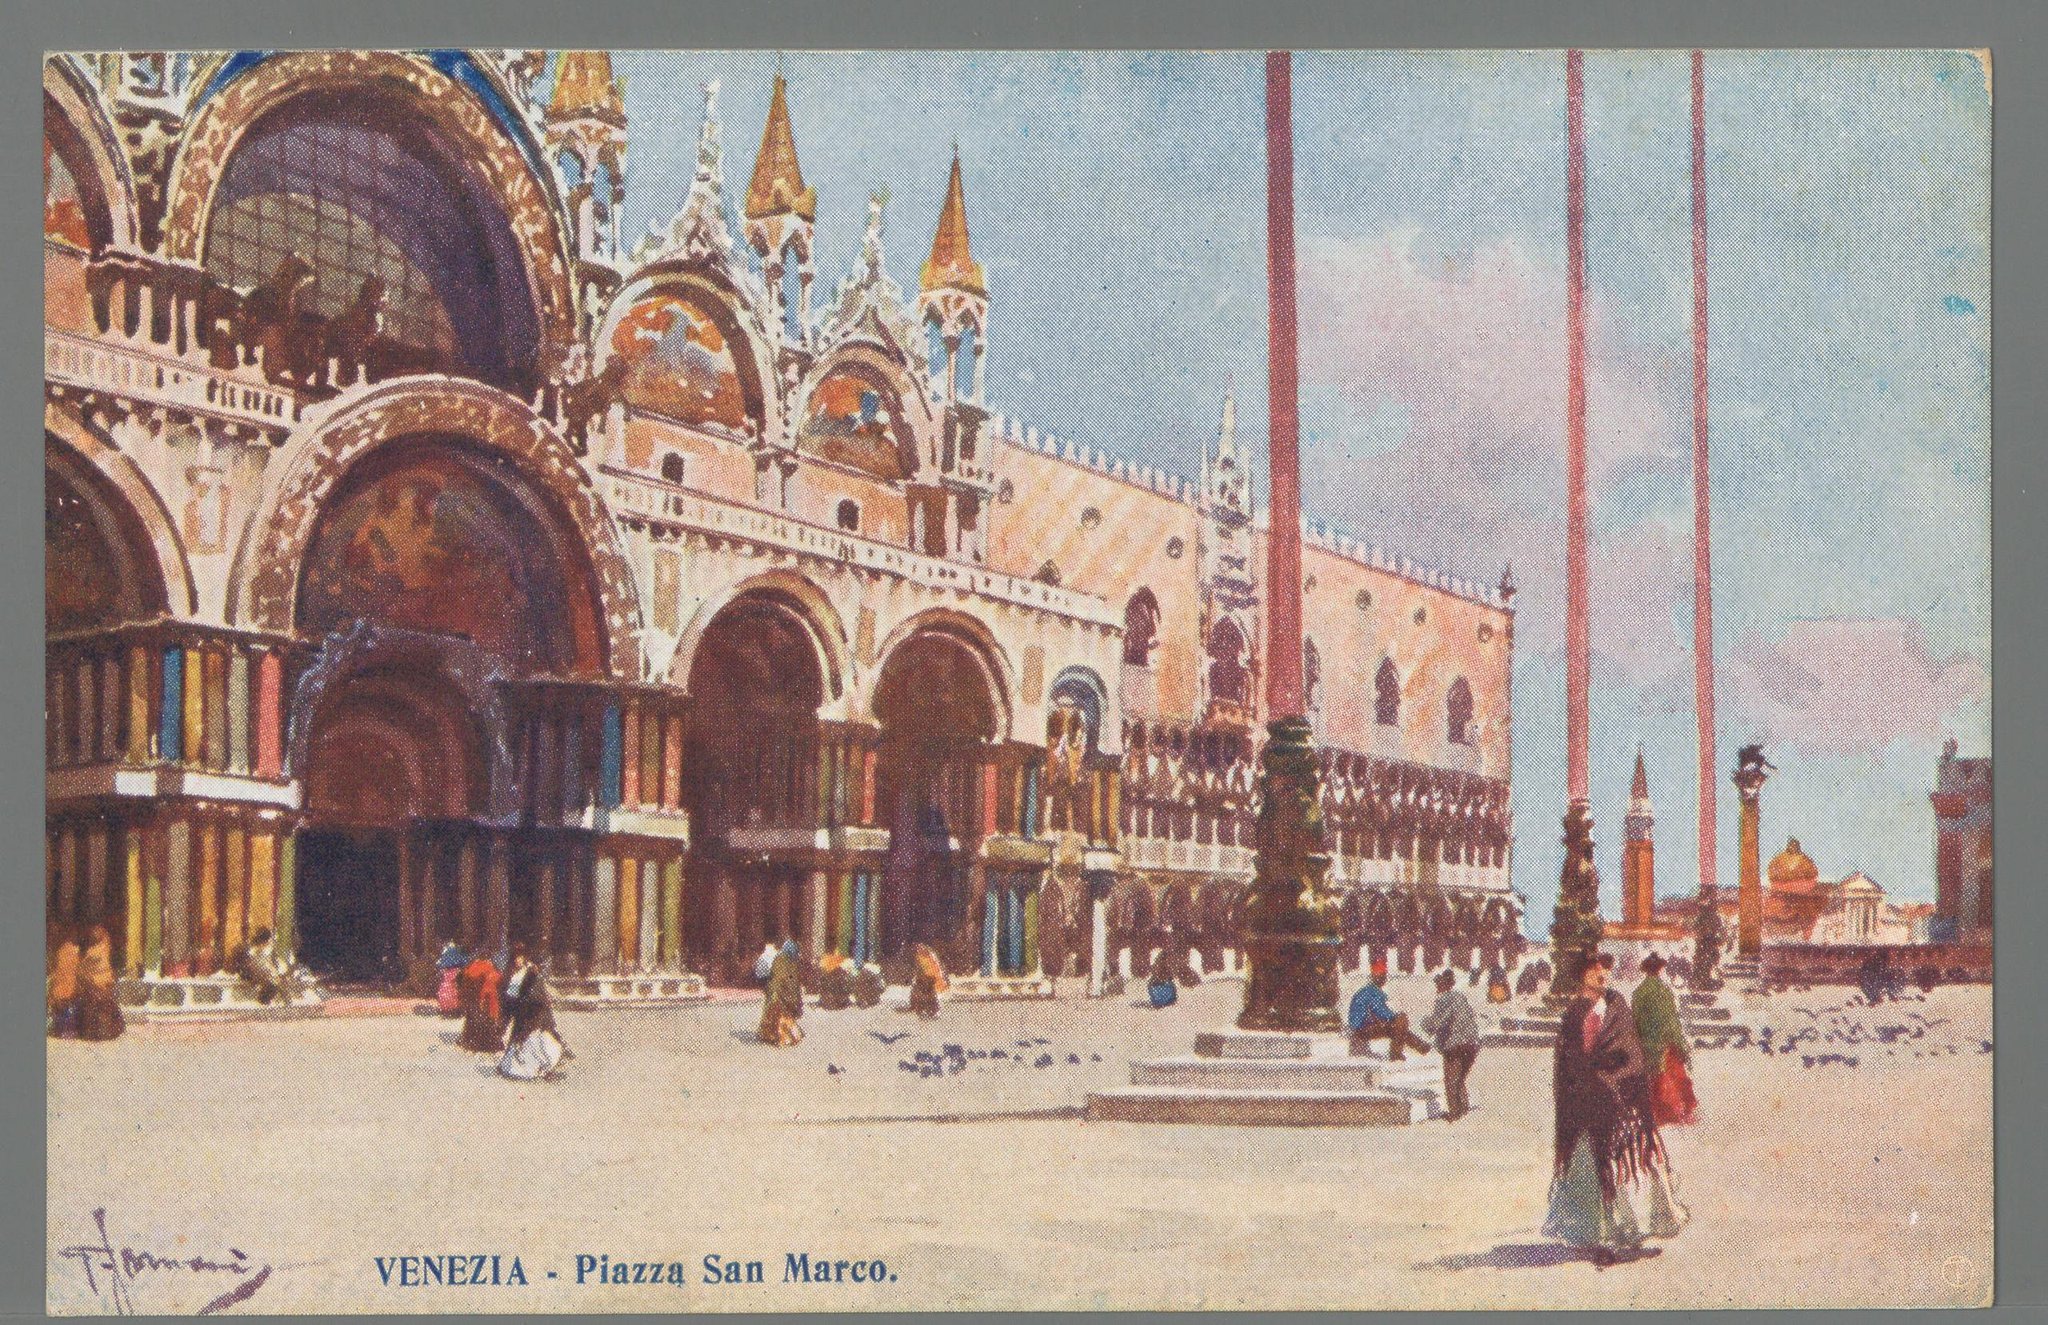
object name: reproduction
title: Venezia. Piazza San Marco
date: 1906-1930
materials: cardboard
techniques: three-color autotype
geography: milan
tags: palace, square, place, circus, etc. (+ city(-scape) with figures, staffage)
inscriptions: signature